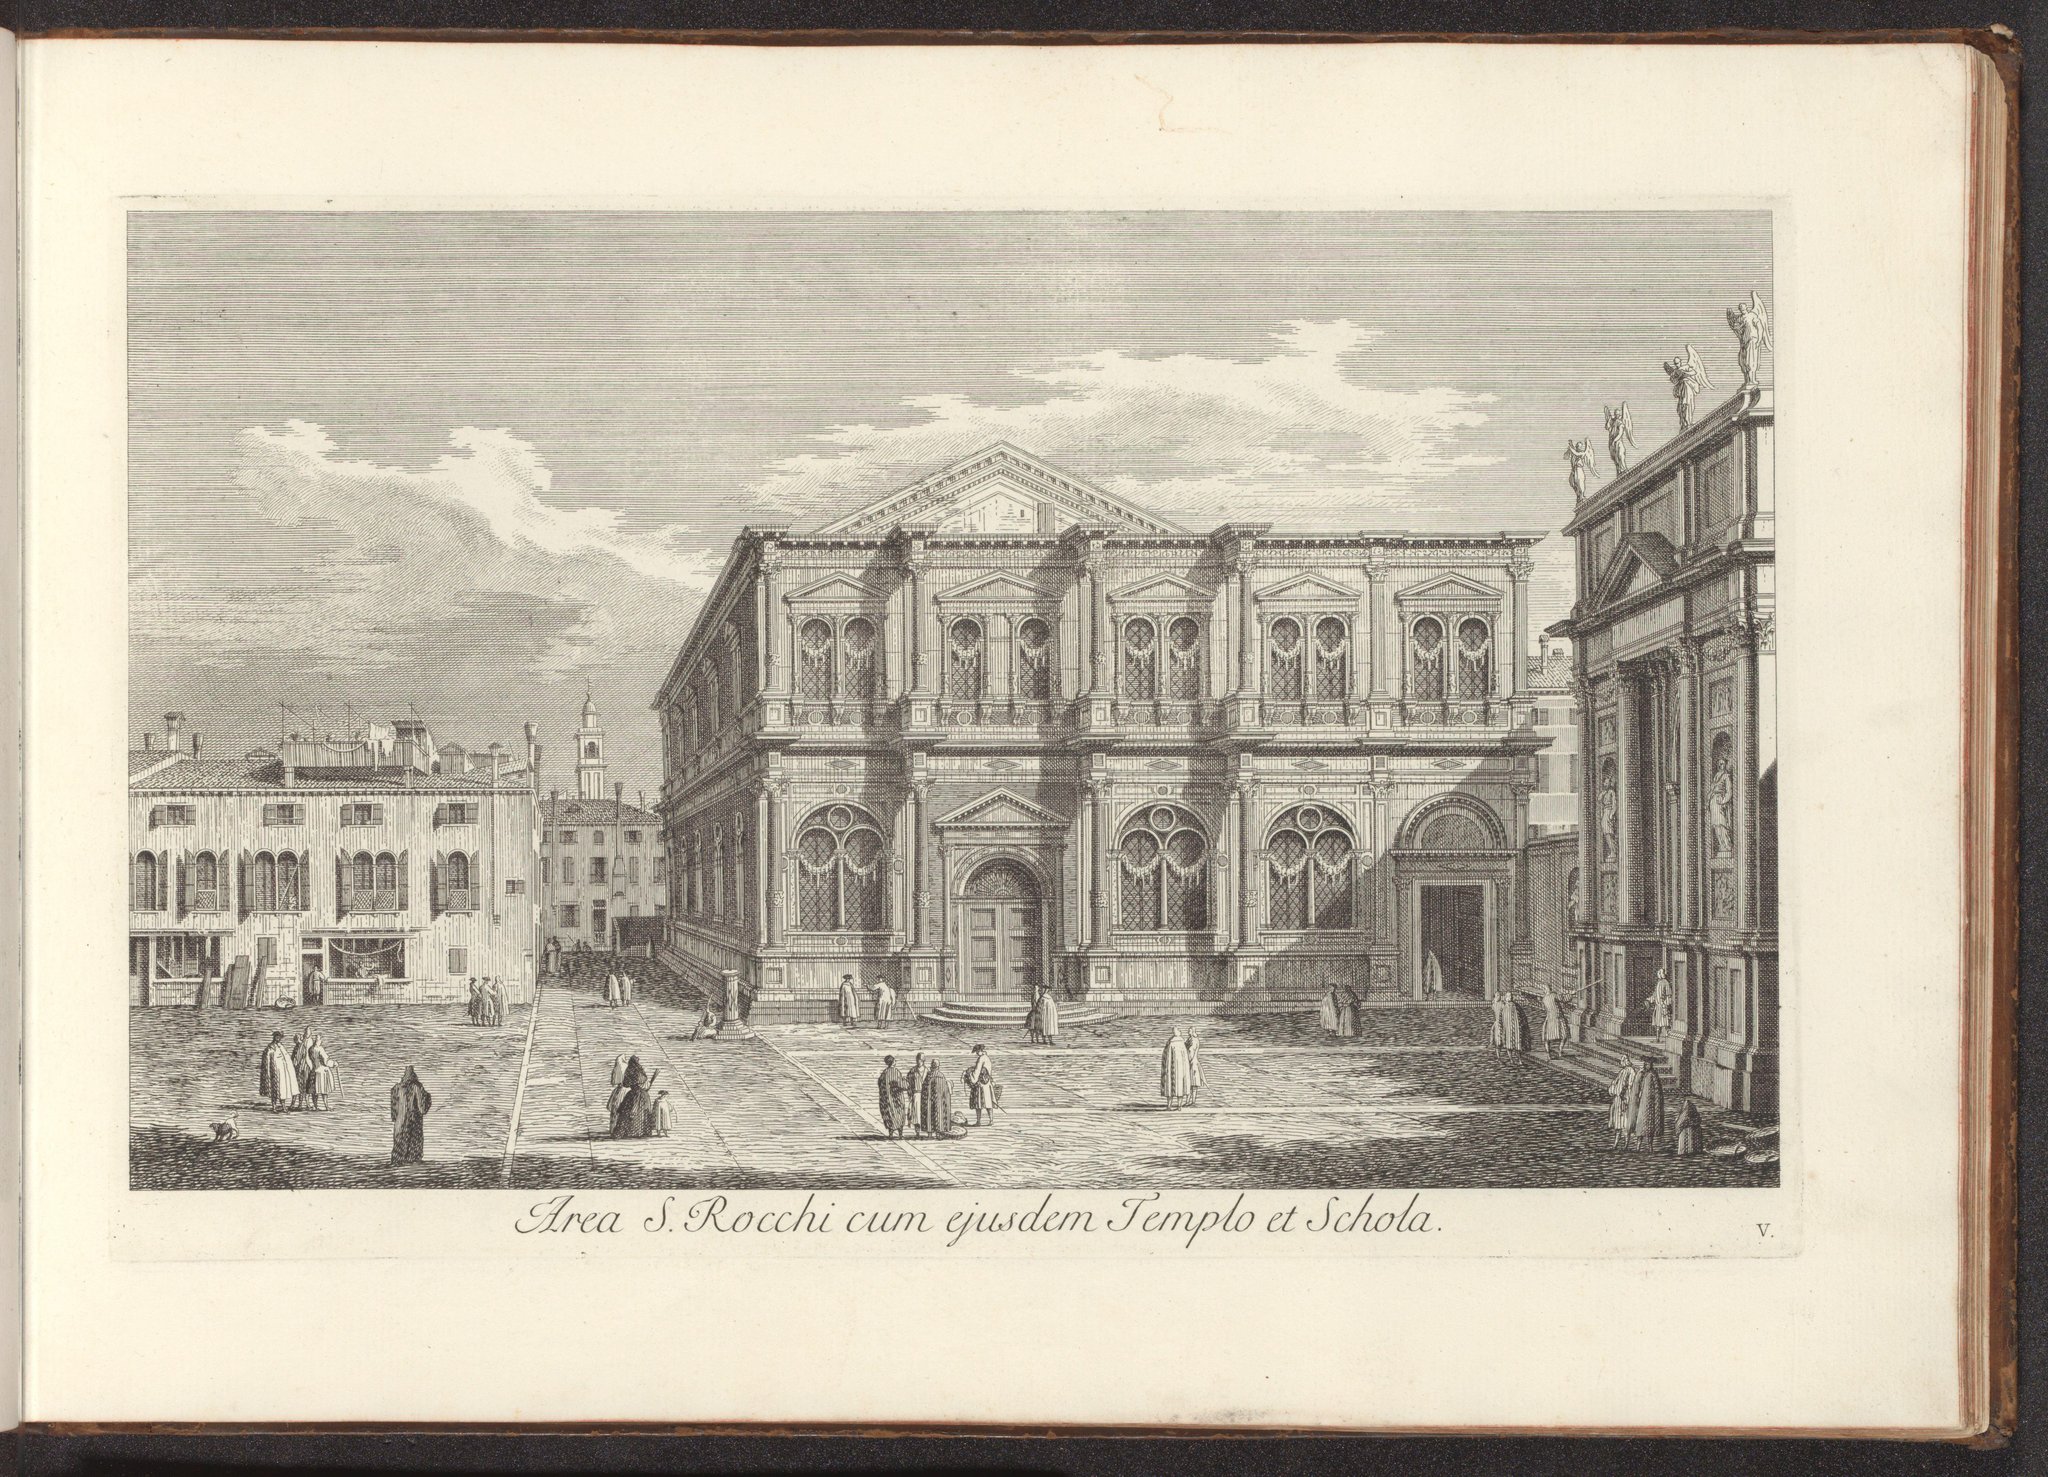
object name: album leaf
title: Area S. Rocchi cum ejusdem Templo et Schola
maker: antonio visentini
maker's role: draughtsman, print maker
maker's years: 1688-1782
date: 1742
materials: paper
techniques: etching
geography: venice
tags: square, place, circus, etc., city-view, and landscape with man-made constructions, canal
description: Gezicht op Campo San Rocco te Venetië, met de Scuola Grande di San Rocco. De prent maakt deel uit van een album.